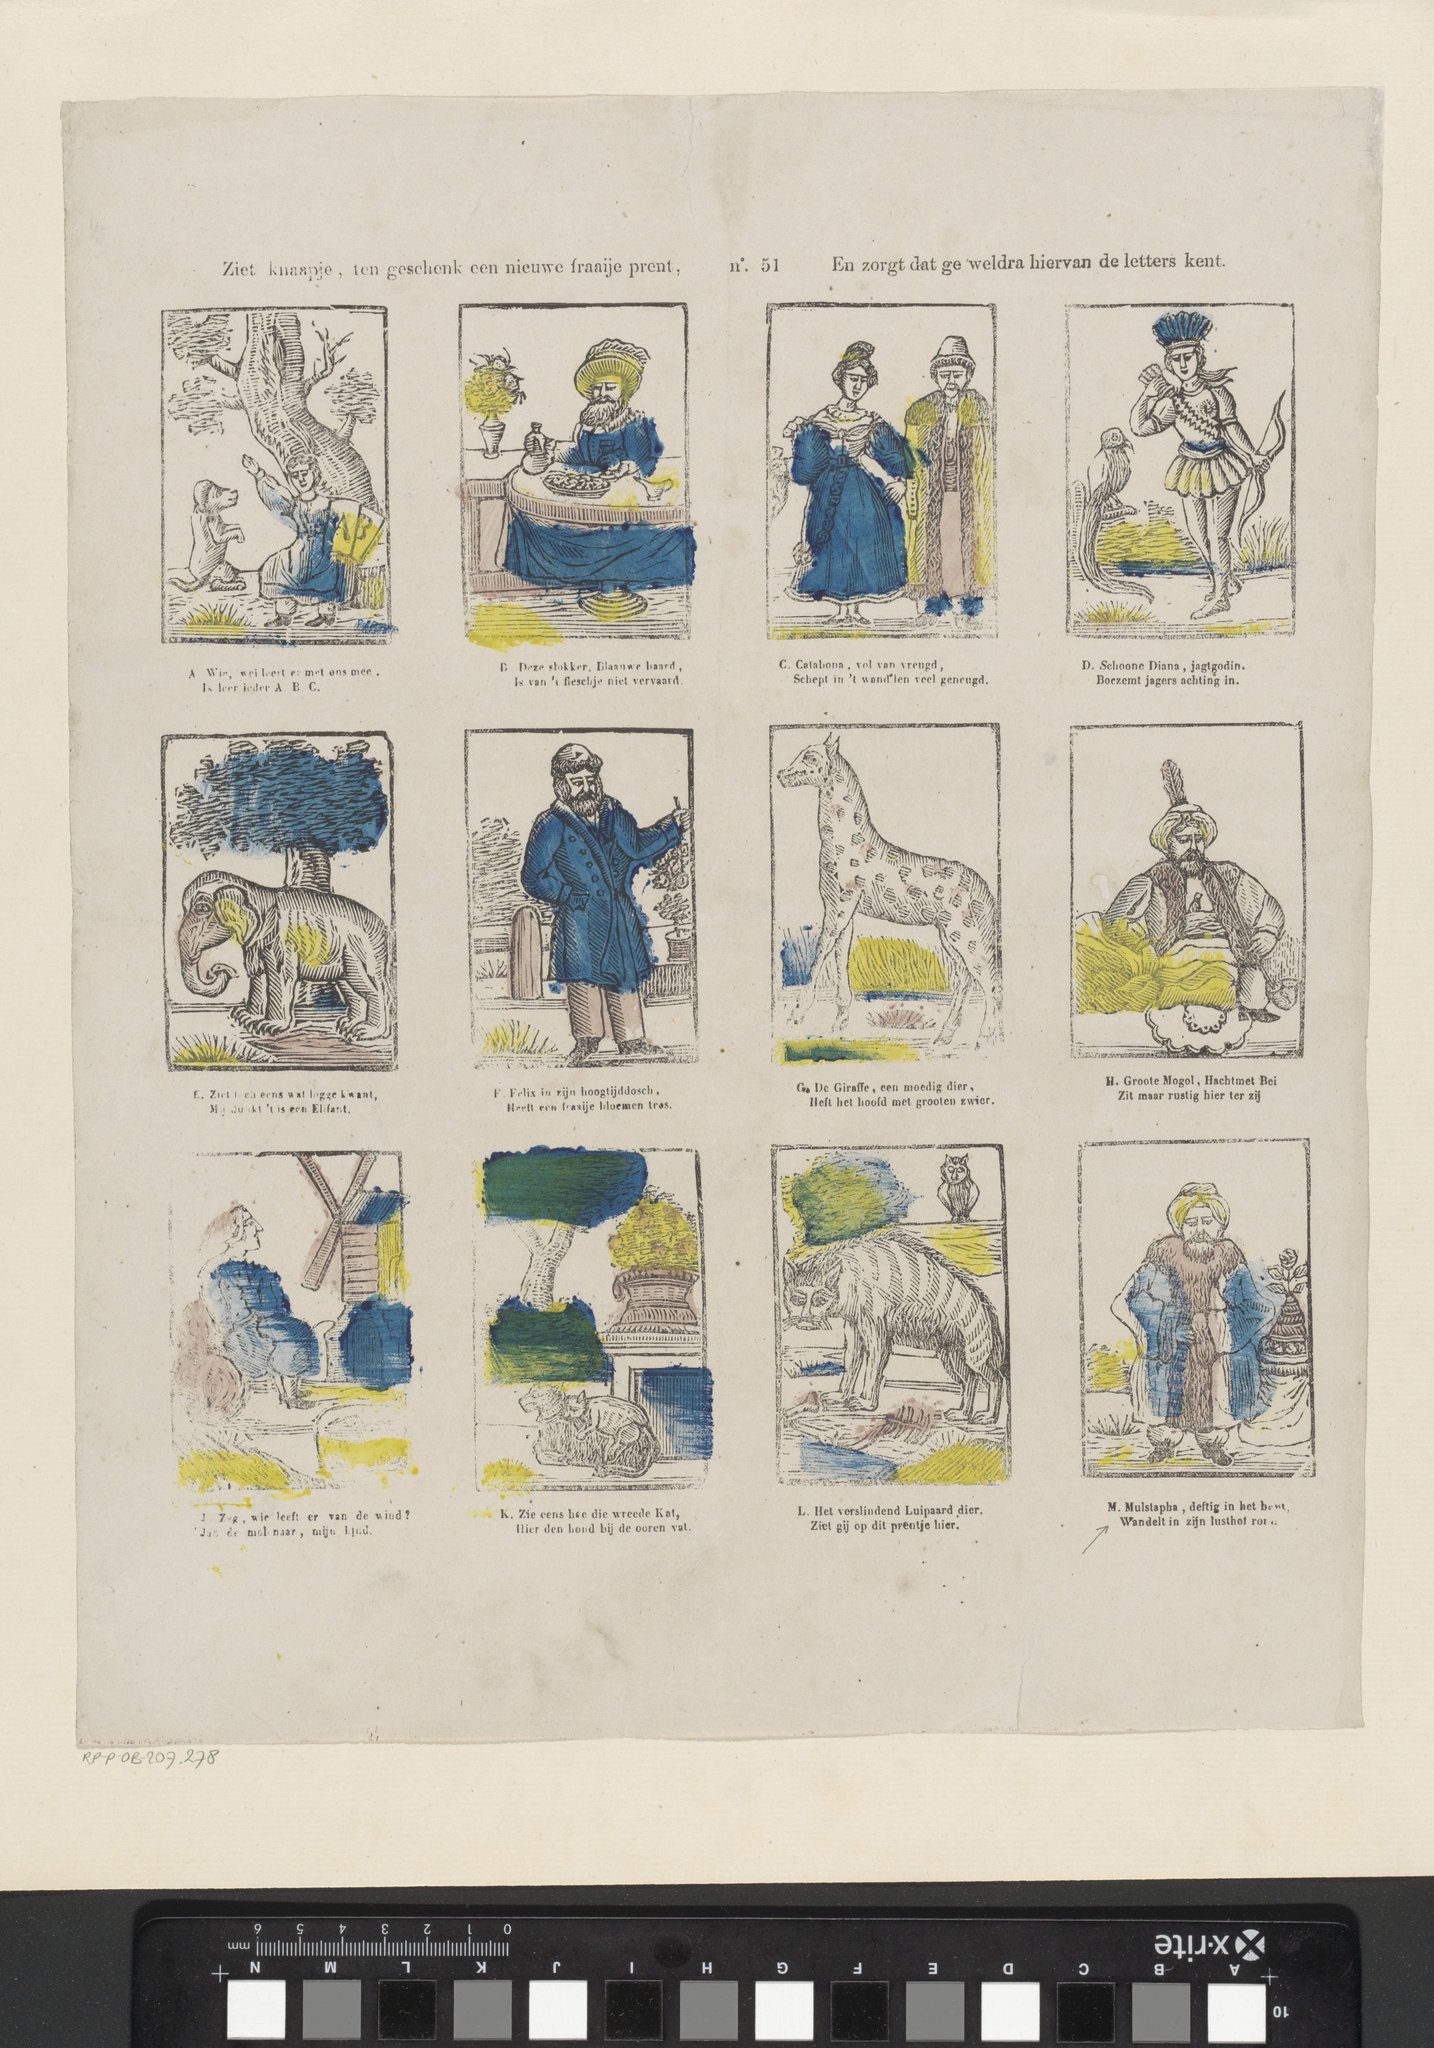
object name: print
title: Ziet knaapje, ten geschenk een nieuwe fraaije prent, / En zorgt dat ge weldra hiervan de letters kent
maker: Anonymous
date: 1848-1881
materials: paper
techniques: colour, letterpress printing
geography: netherlands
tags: animals, human types, letters, alphabet, script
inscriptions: collector's mark: Lugt 2760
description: Blad met 12 voorstellingen van de letters (A-M) van het alfabet geïllustreerd met figuren en dieren waarvan de woorden met de betreffende letter beginnen. Onder elke afbeelding een tweeregelig vers. Genummerd midden boven: no. 51.